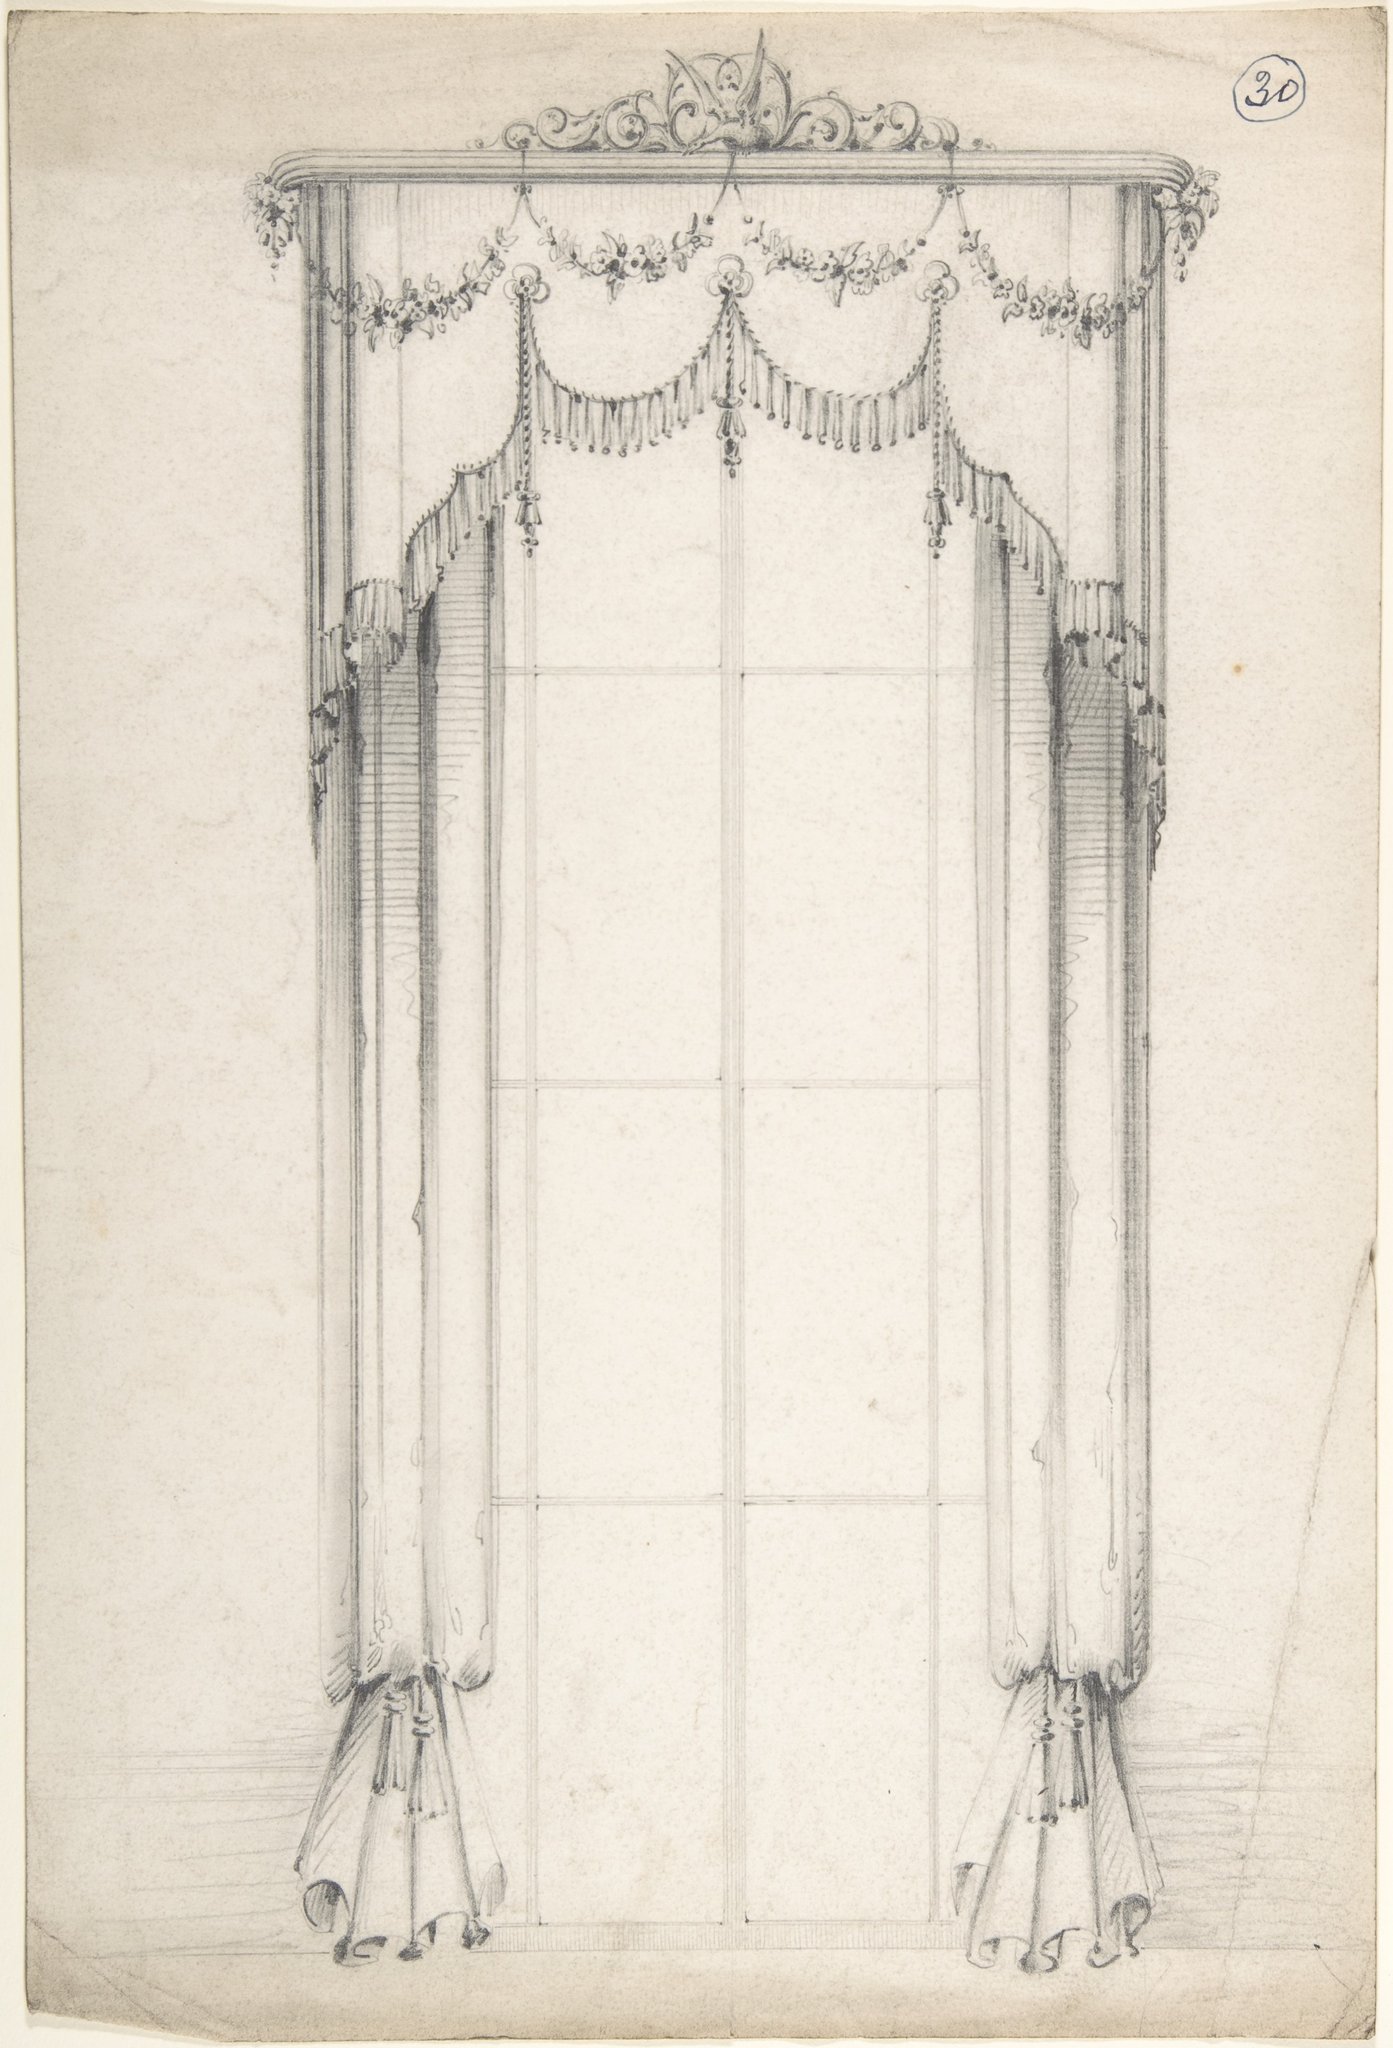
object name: drawing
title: Design for Curtains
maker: charles hindley and sons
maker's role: artist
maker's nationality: british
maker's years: 1841-1917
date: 1841-1917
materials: graphite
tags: curtains